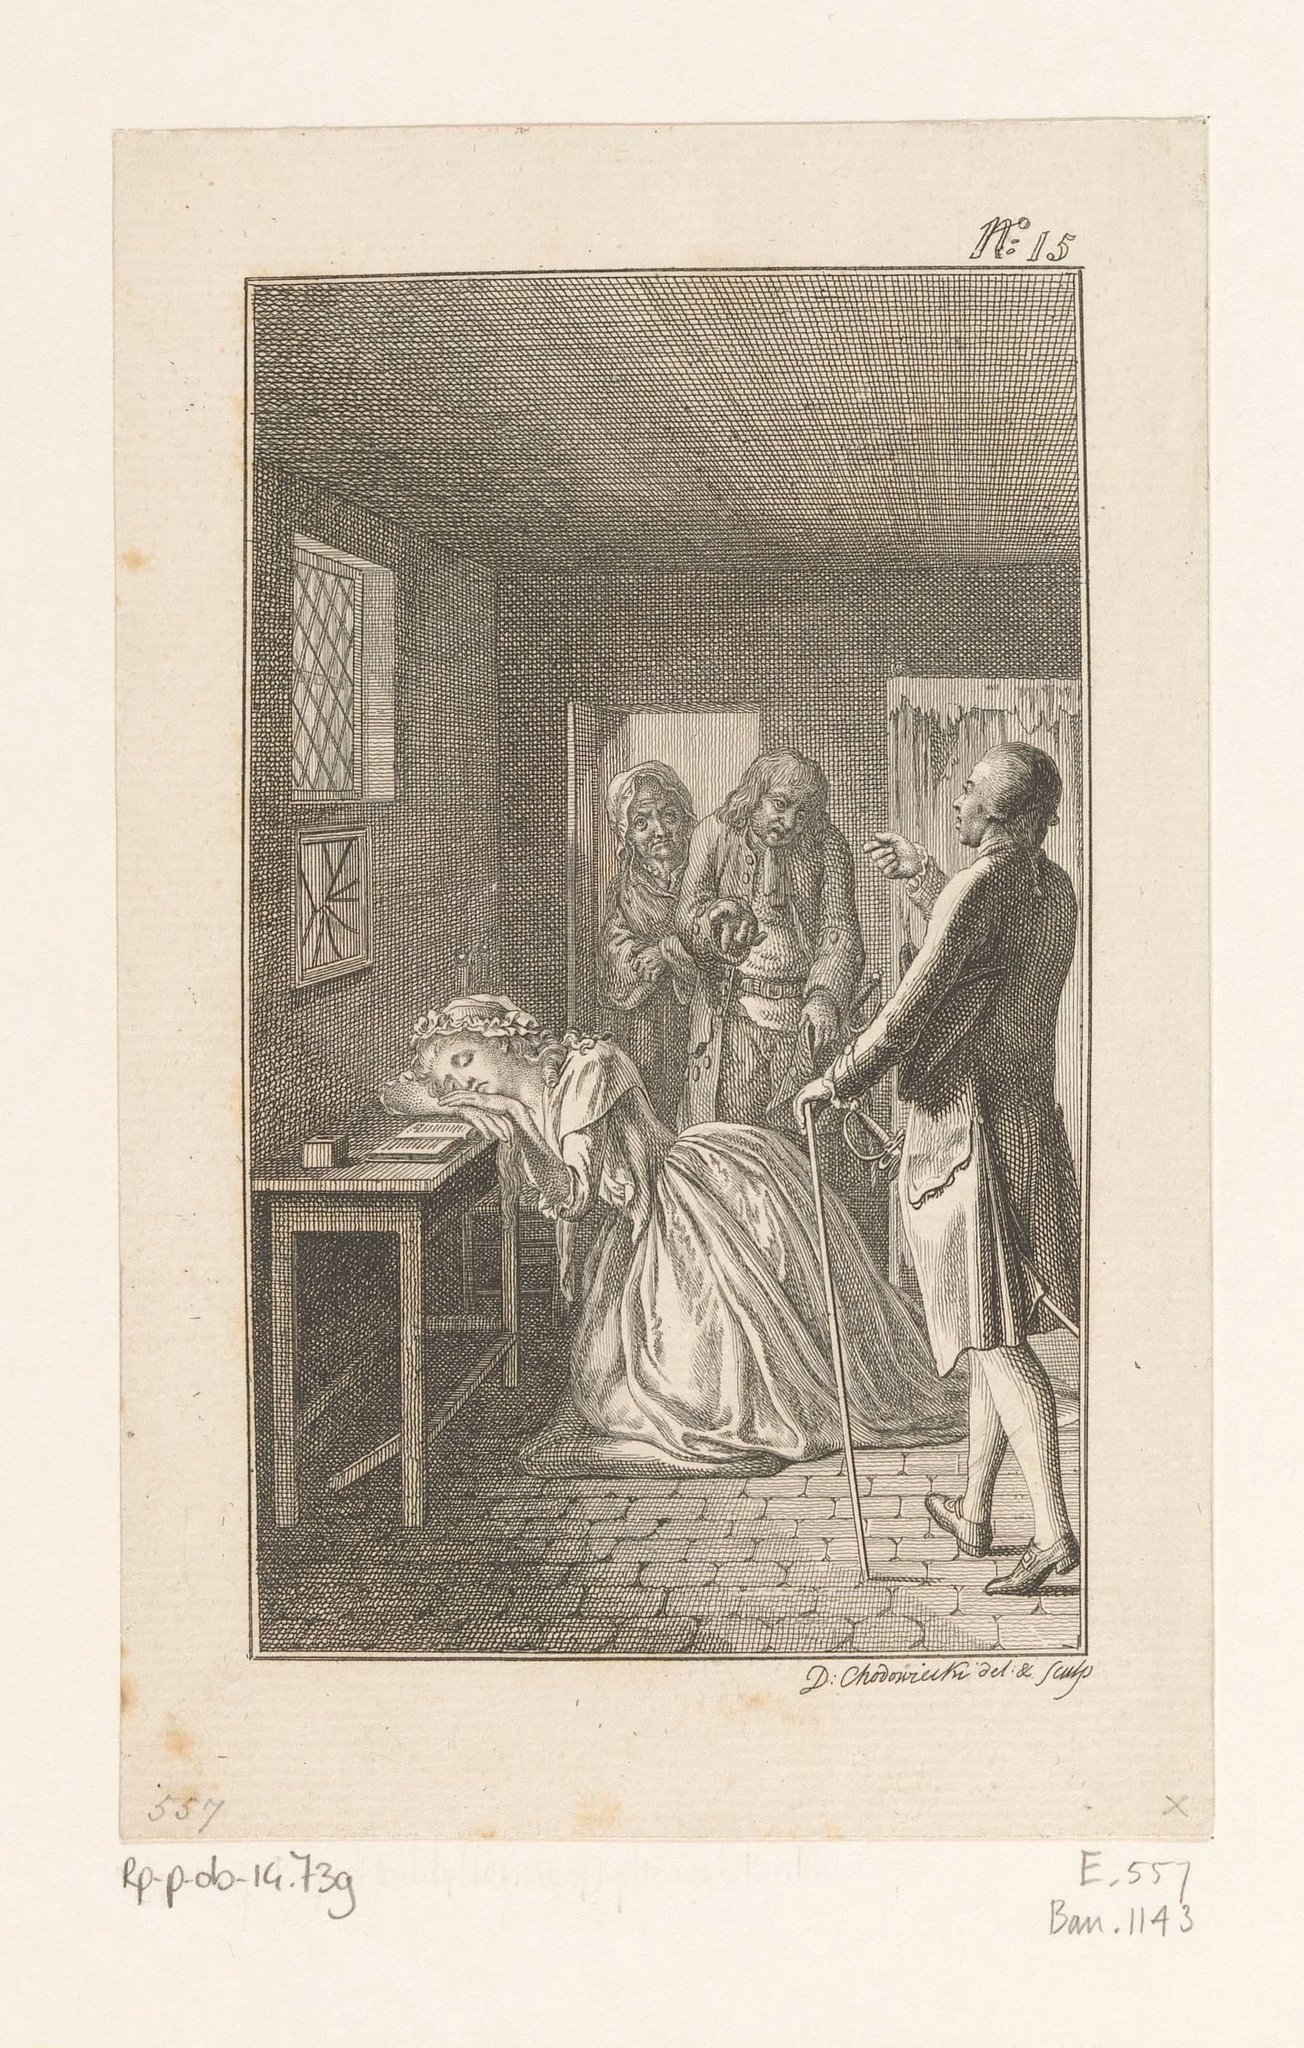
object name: print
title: Belford bezoekt Clarissa in de kerker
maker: daniel nikolaus chodowiecki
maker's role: draughtsman, print maker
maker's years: 1726-1801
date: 1784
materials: paper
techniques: etching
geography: berlin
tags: prison, jail, literature, death penalty, execution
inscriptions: collector's mark: Lugt 2228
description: Prent gebruikt voor: Richardson, Samuel. Clarisse Harlowe, Traduction nouvelle et seule complete par (...). 14 dln. Genève en Parijs: Barde, 1785-87.